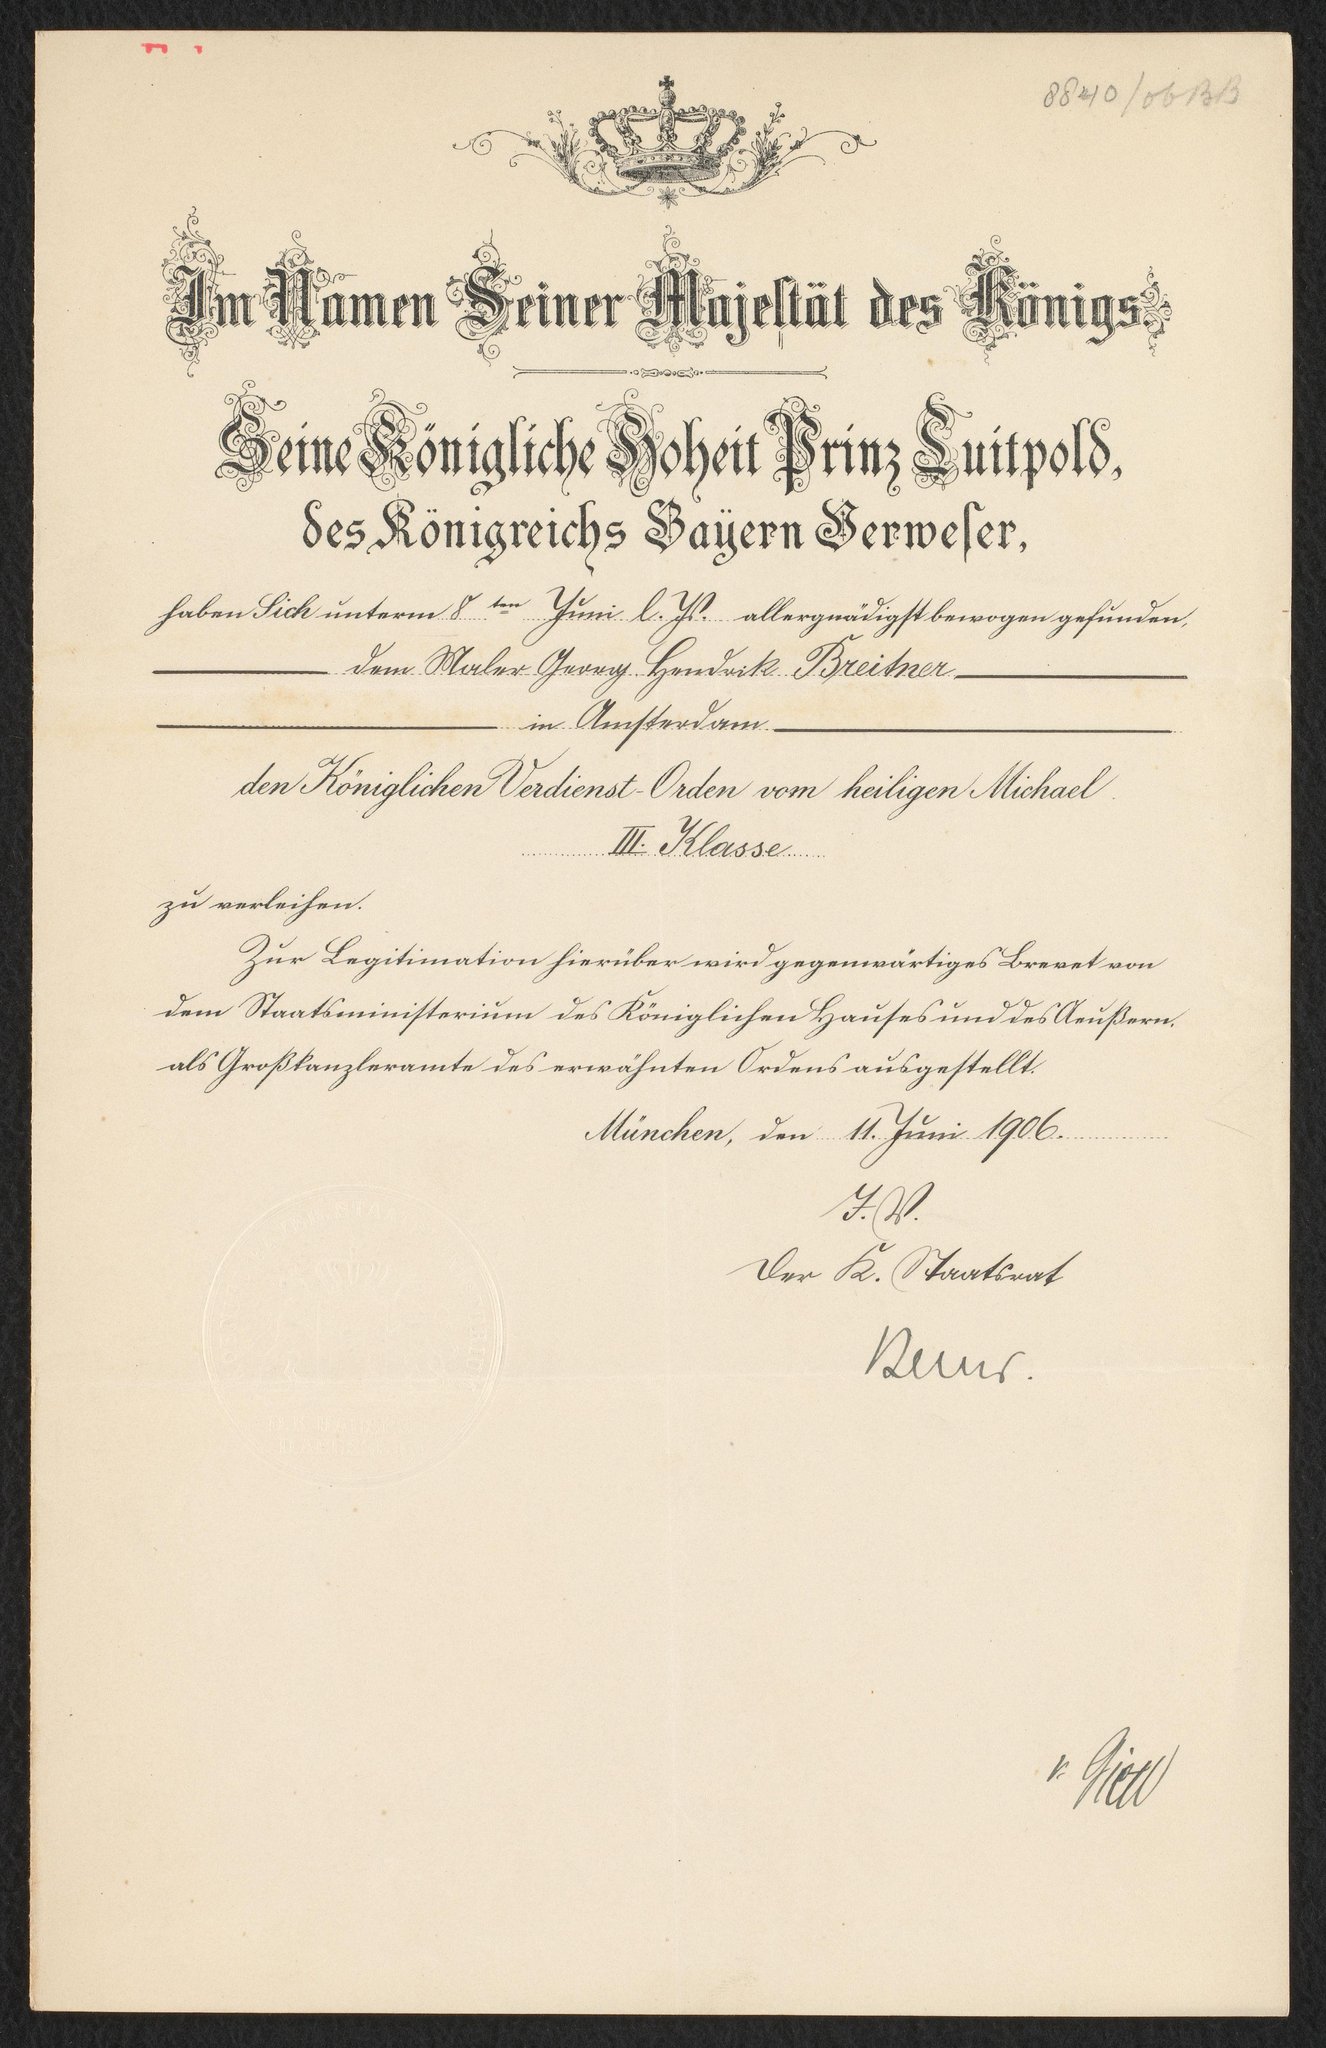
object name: document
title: Benoeming van Georg Hendrik Breitner als ridder derde klasse in de Orde van St. Michaël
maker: Anonymous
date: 1906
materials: ink, paper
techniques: blind stamped, letterpress printing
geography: germany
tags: rotterdam, amsterdam, painter, print maker, draughtsman, george hendrik breitner, distribution of awards ~ art contest